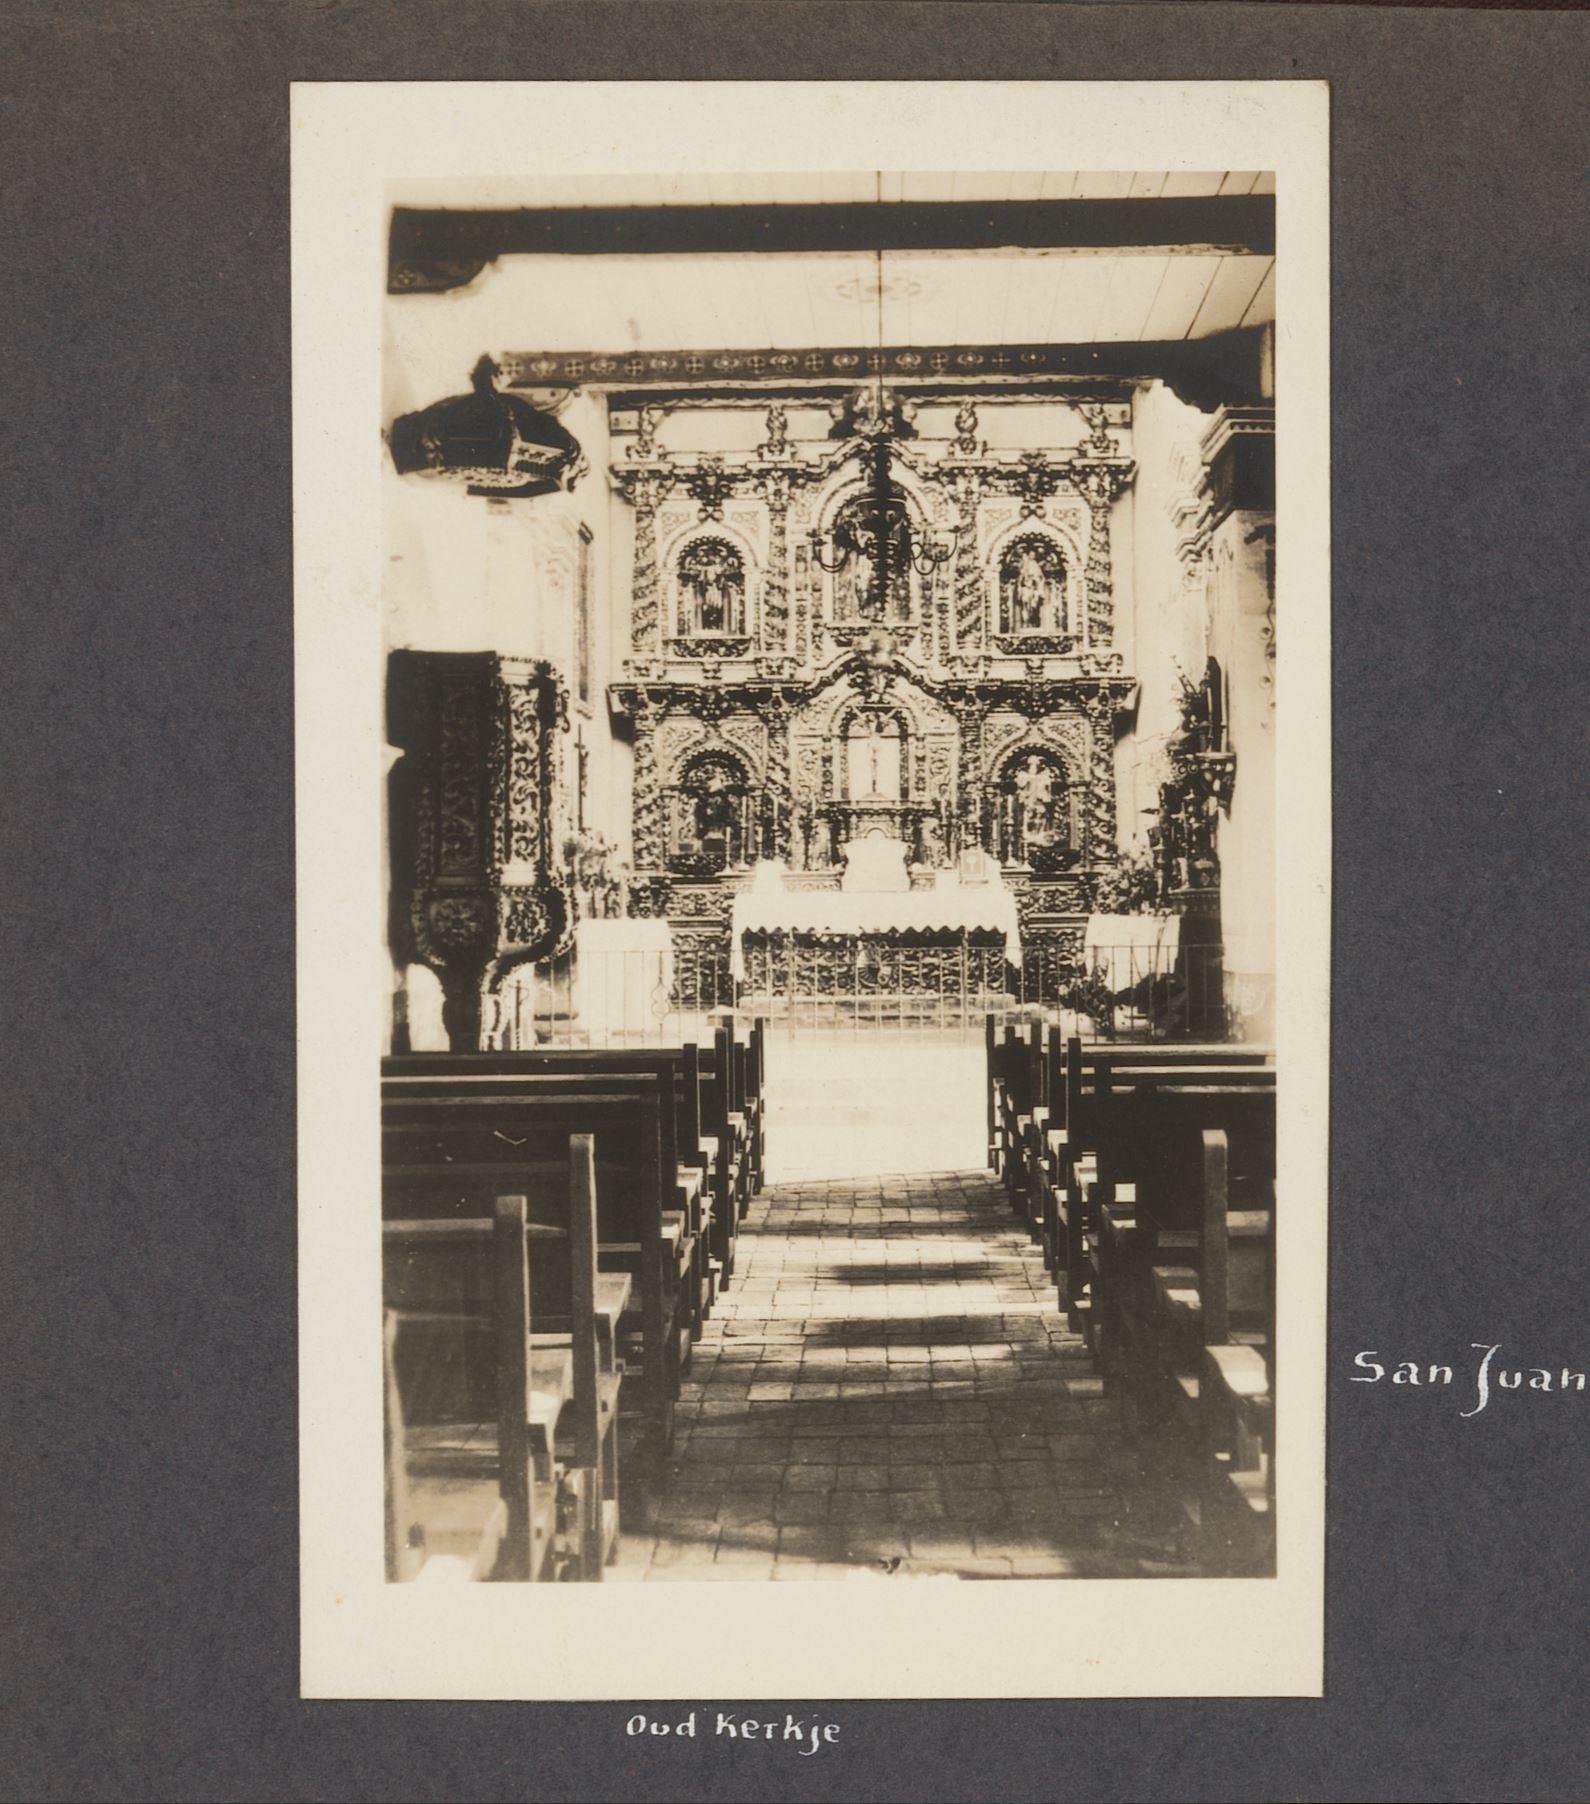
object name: photograph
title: Kerkinterieur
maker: Anonymous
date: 1928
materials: photographic support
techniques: gelatin silver print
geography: san juan capistrano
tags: interior of church, altar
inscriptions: annotation: ‘oud kerkje’